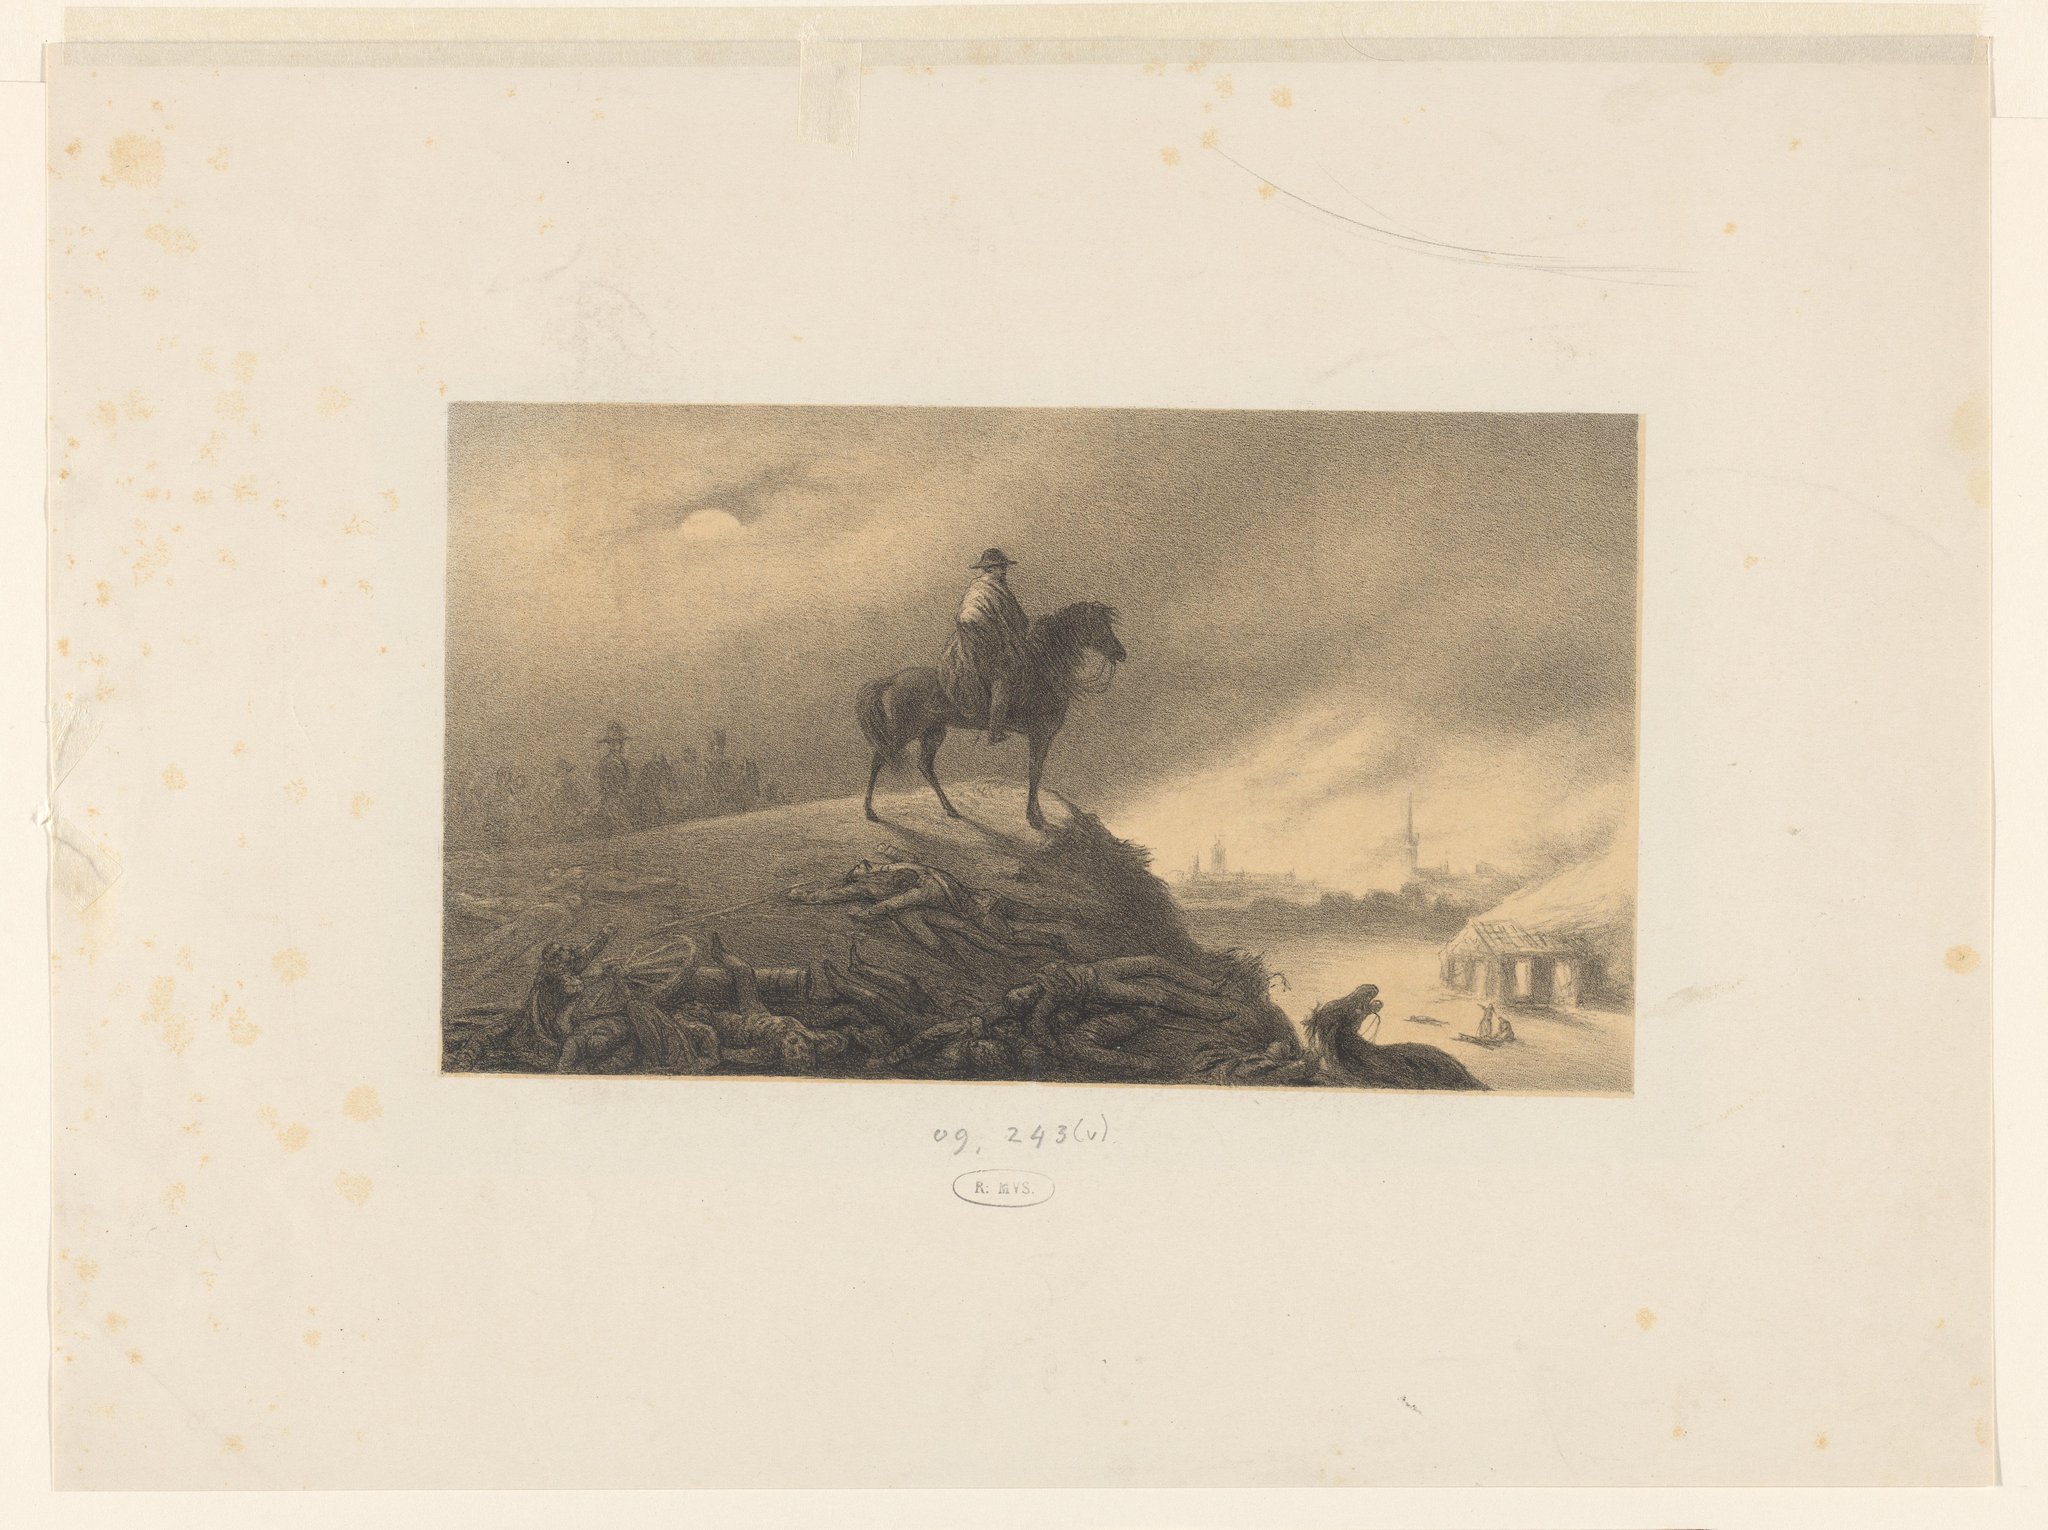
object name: print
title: Napoleon te paard, op een slagveld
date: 1832-1897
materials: paper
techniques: tone lithography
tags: napoleon i (emperor of the french), riding a horse, ass, or mule; rider, horseman, battle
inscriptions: collector's mark: Lugt 2228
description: Napoleon te paard staat op een heuvel en kijkt uit over brandende steden in de achtergrond.